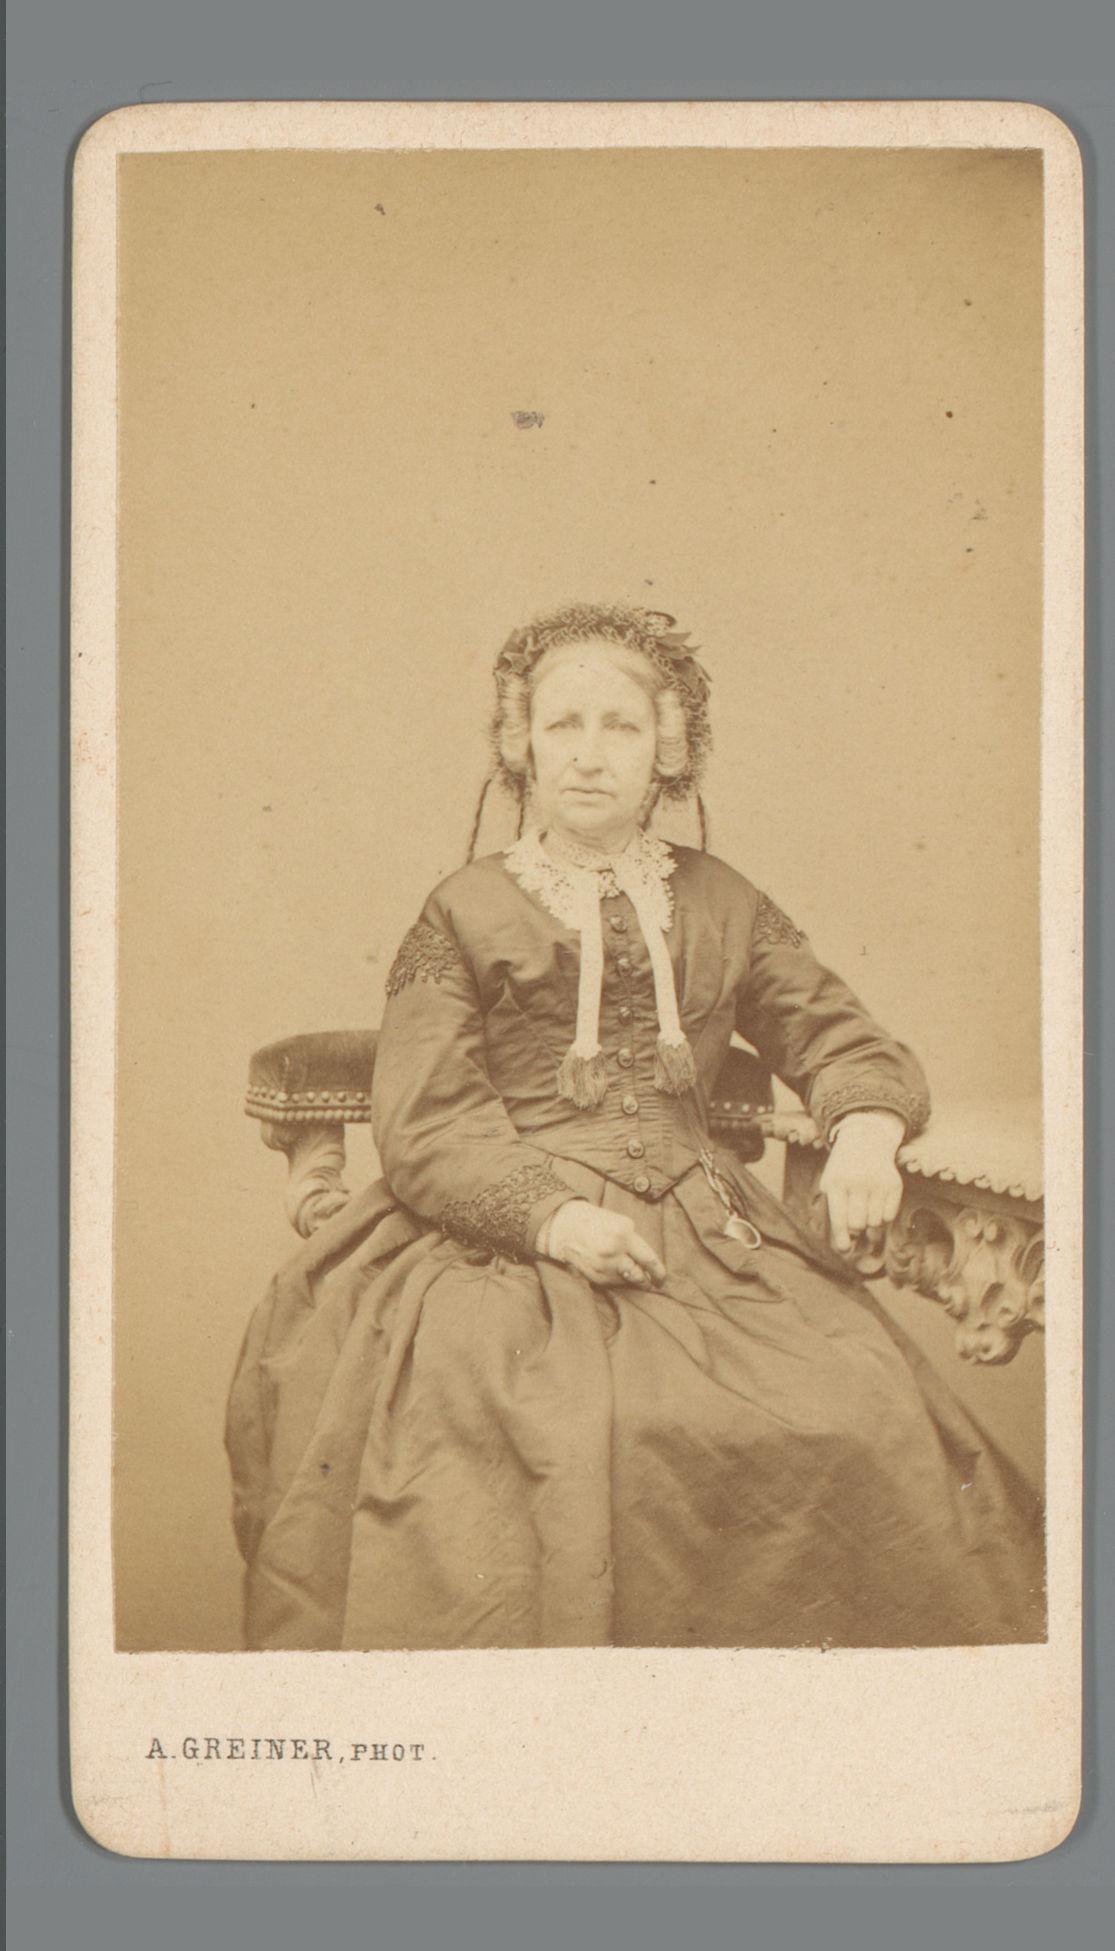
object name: photograph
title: Portret van mevrouw Nije Doorwaard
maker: albert greiner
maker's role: fotograaf, fotostudio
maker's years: 1833-1890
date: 1861-1874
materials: cardboard, photographic support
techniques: albumen print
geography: amsterdam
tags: historical persons - bb - woman, amsterdam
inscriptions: workshop stamp: ‘A. Greiner/ Photograf/ Nieuwendijk L.87, Amsterdam’, annotation: ‘Grootmoeder A.G. Nije-Dooreerdt/ Overgrootmoeder/ moeder van/ Jonker-Nije’